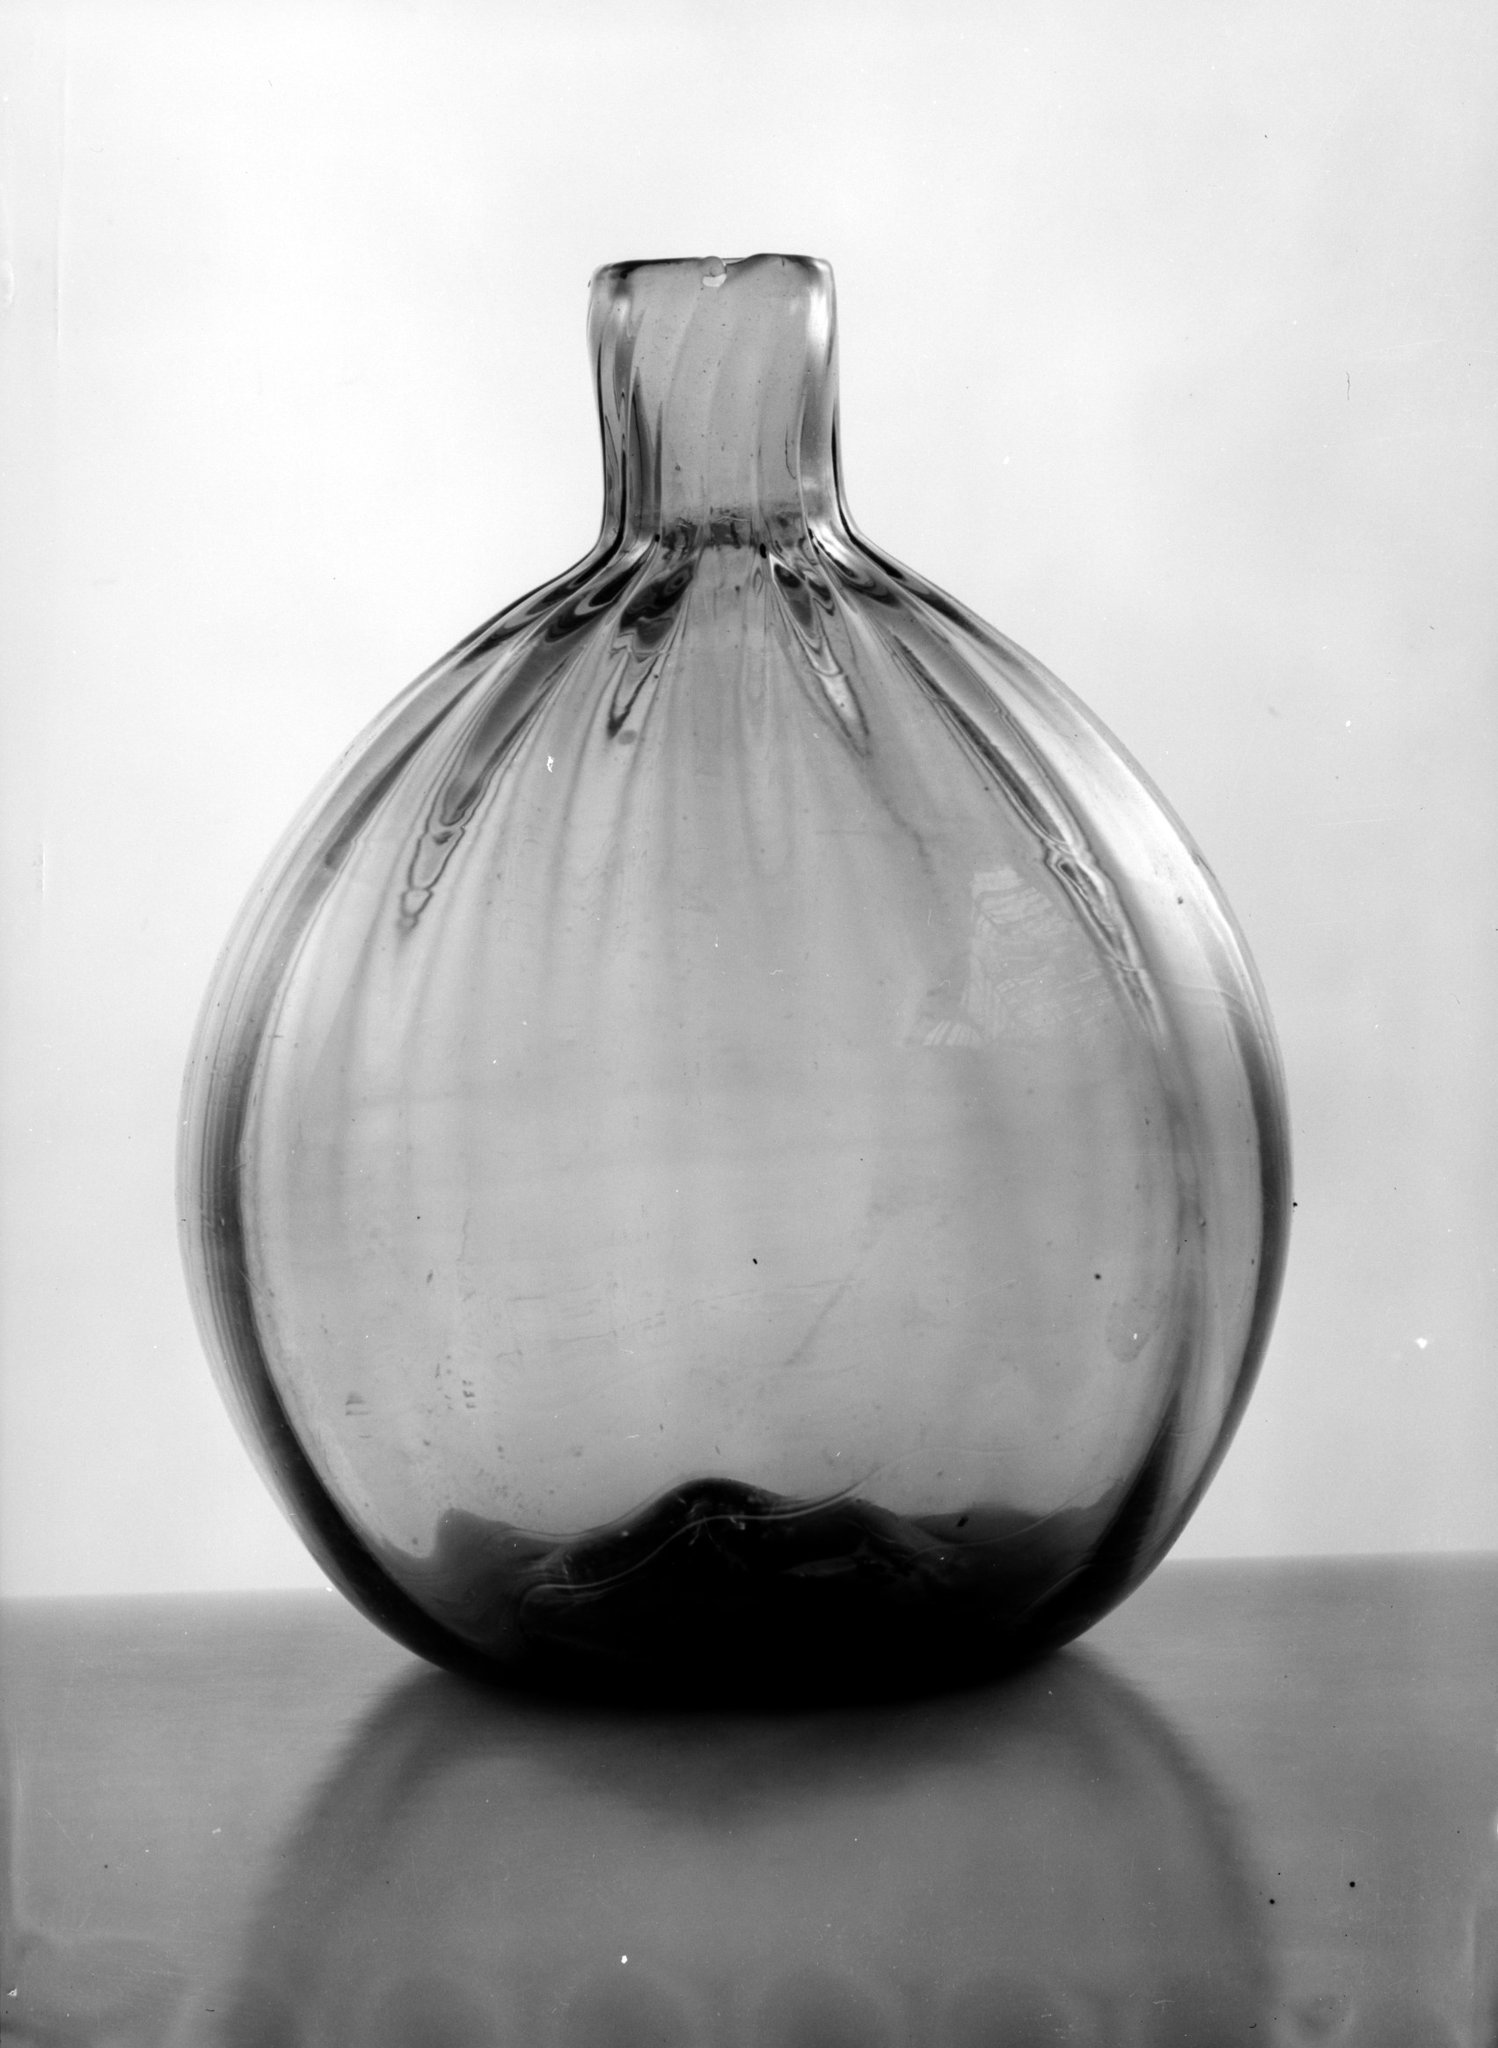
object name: bottle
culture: american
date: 1820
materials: glass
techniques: glassblowing, molding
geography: united states